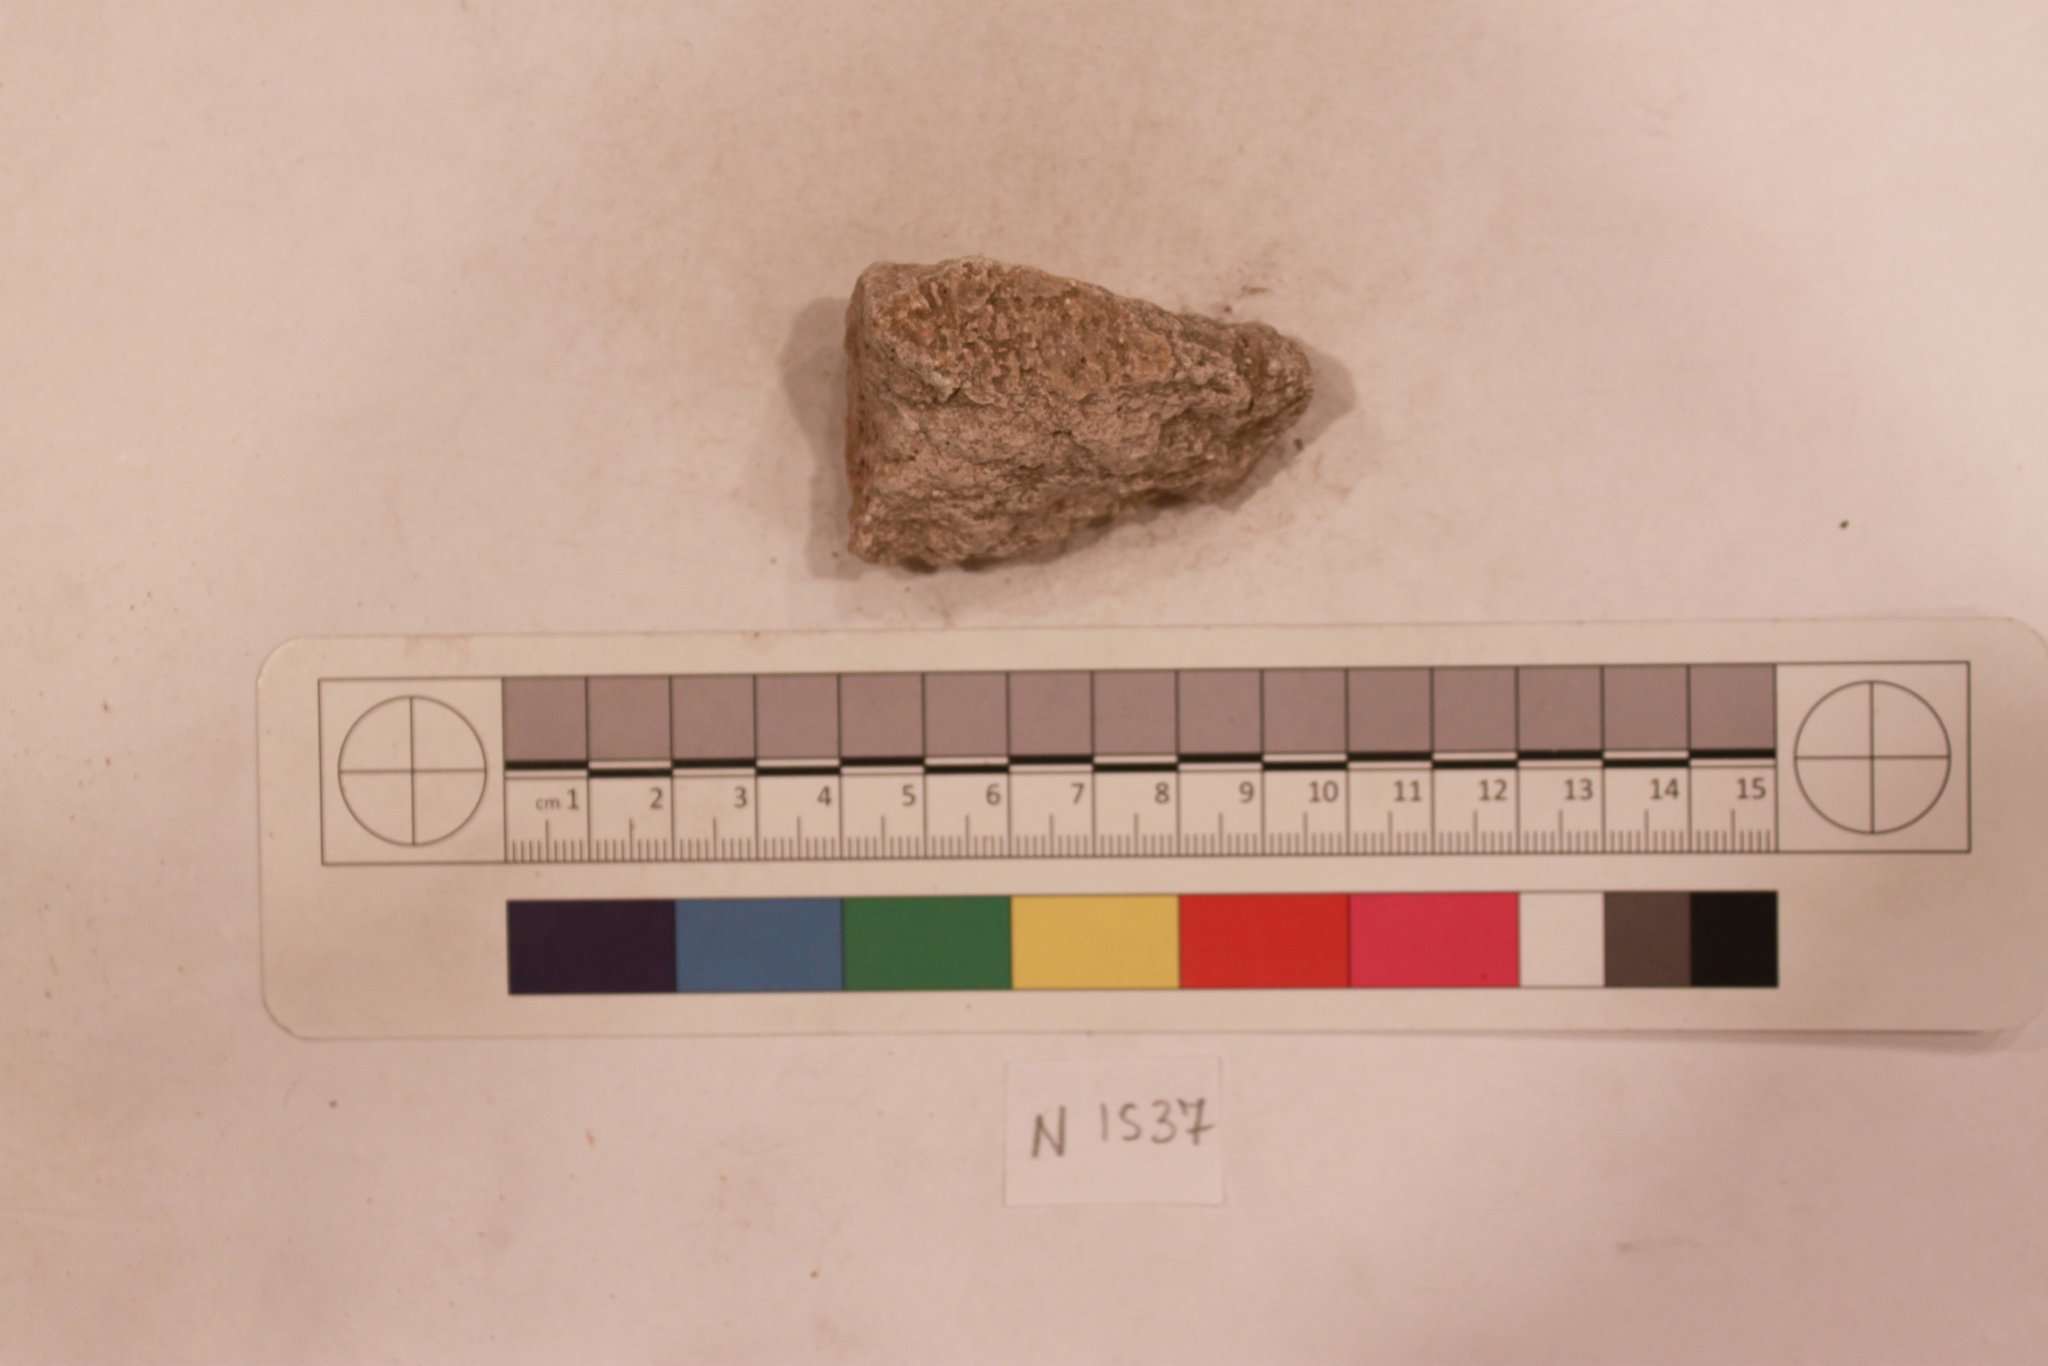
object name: fragment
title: Stucco Fragment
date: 701-1200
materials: plaster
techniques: carving, painting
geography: iran